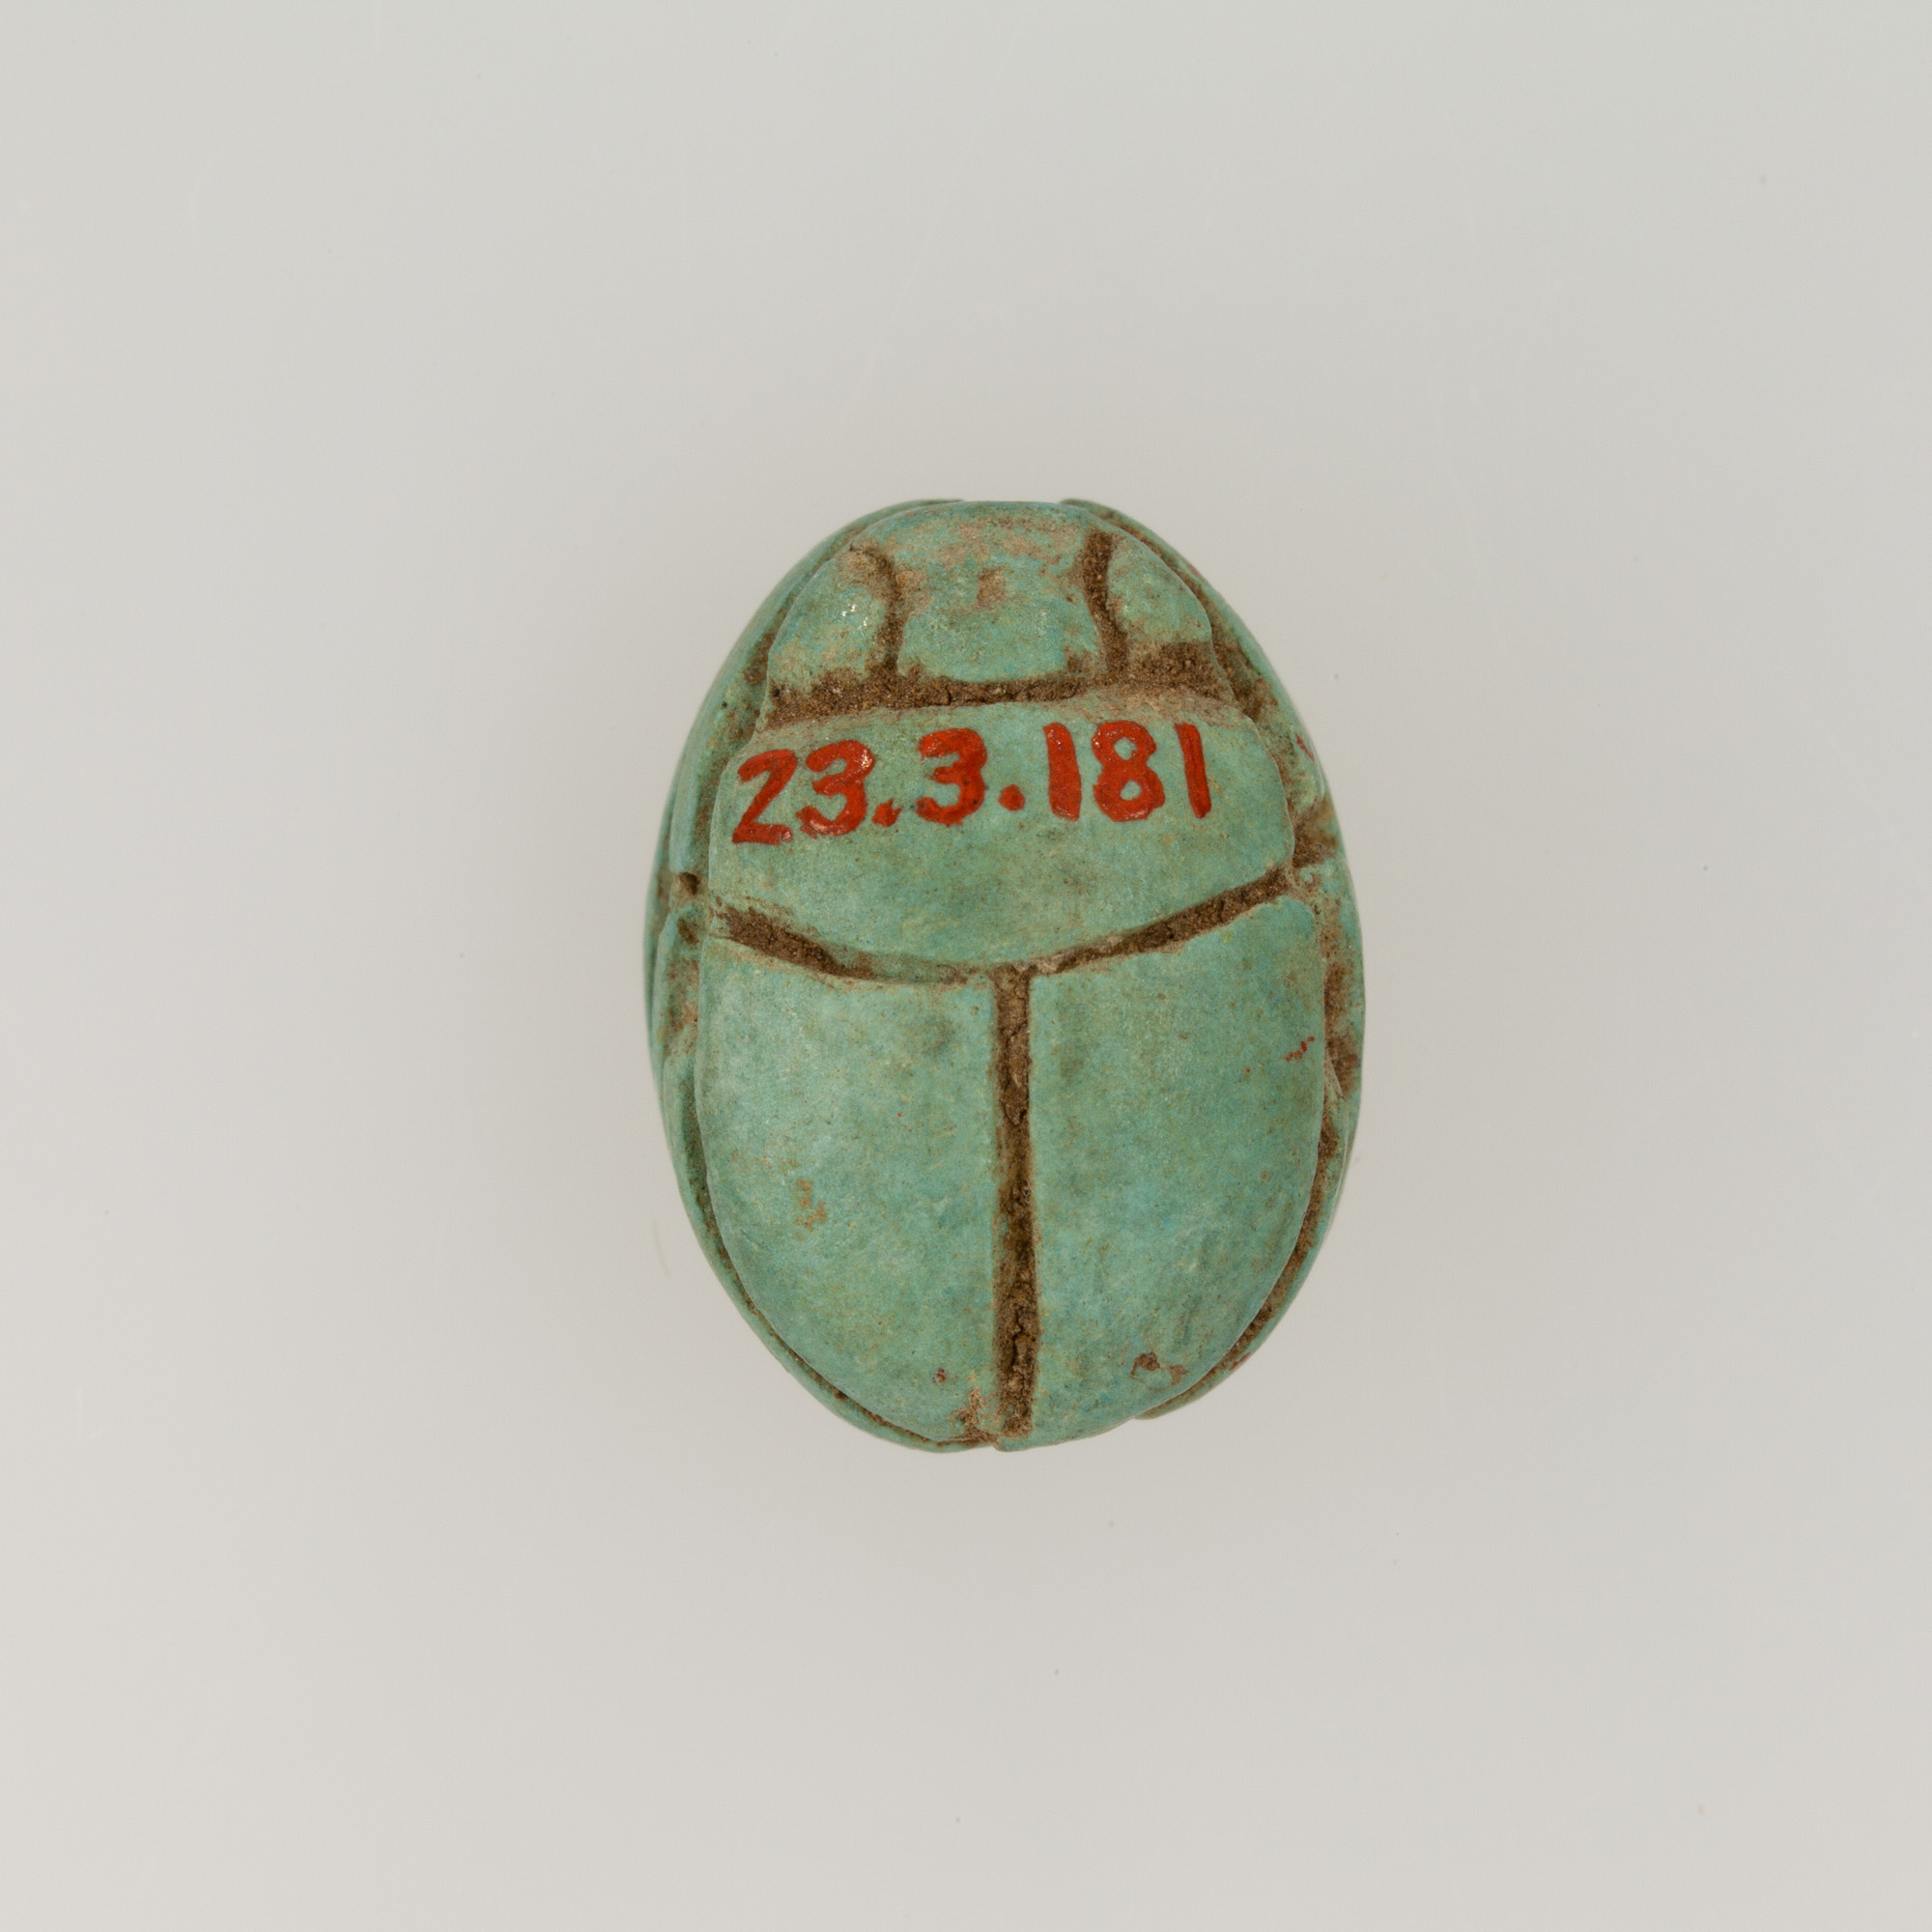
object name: scarab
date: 1479-1458 BCE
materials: faience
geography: egypt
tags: scarabs